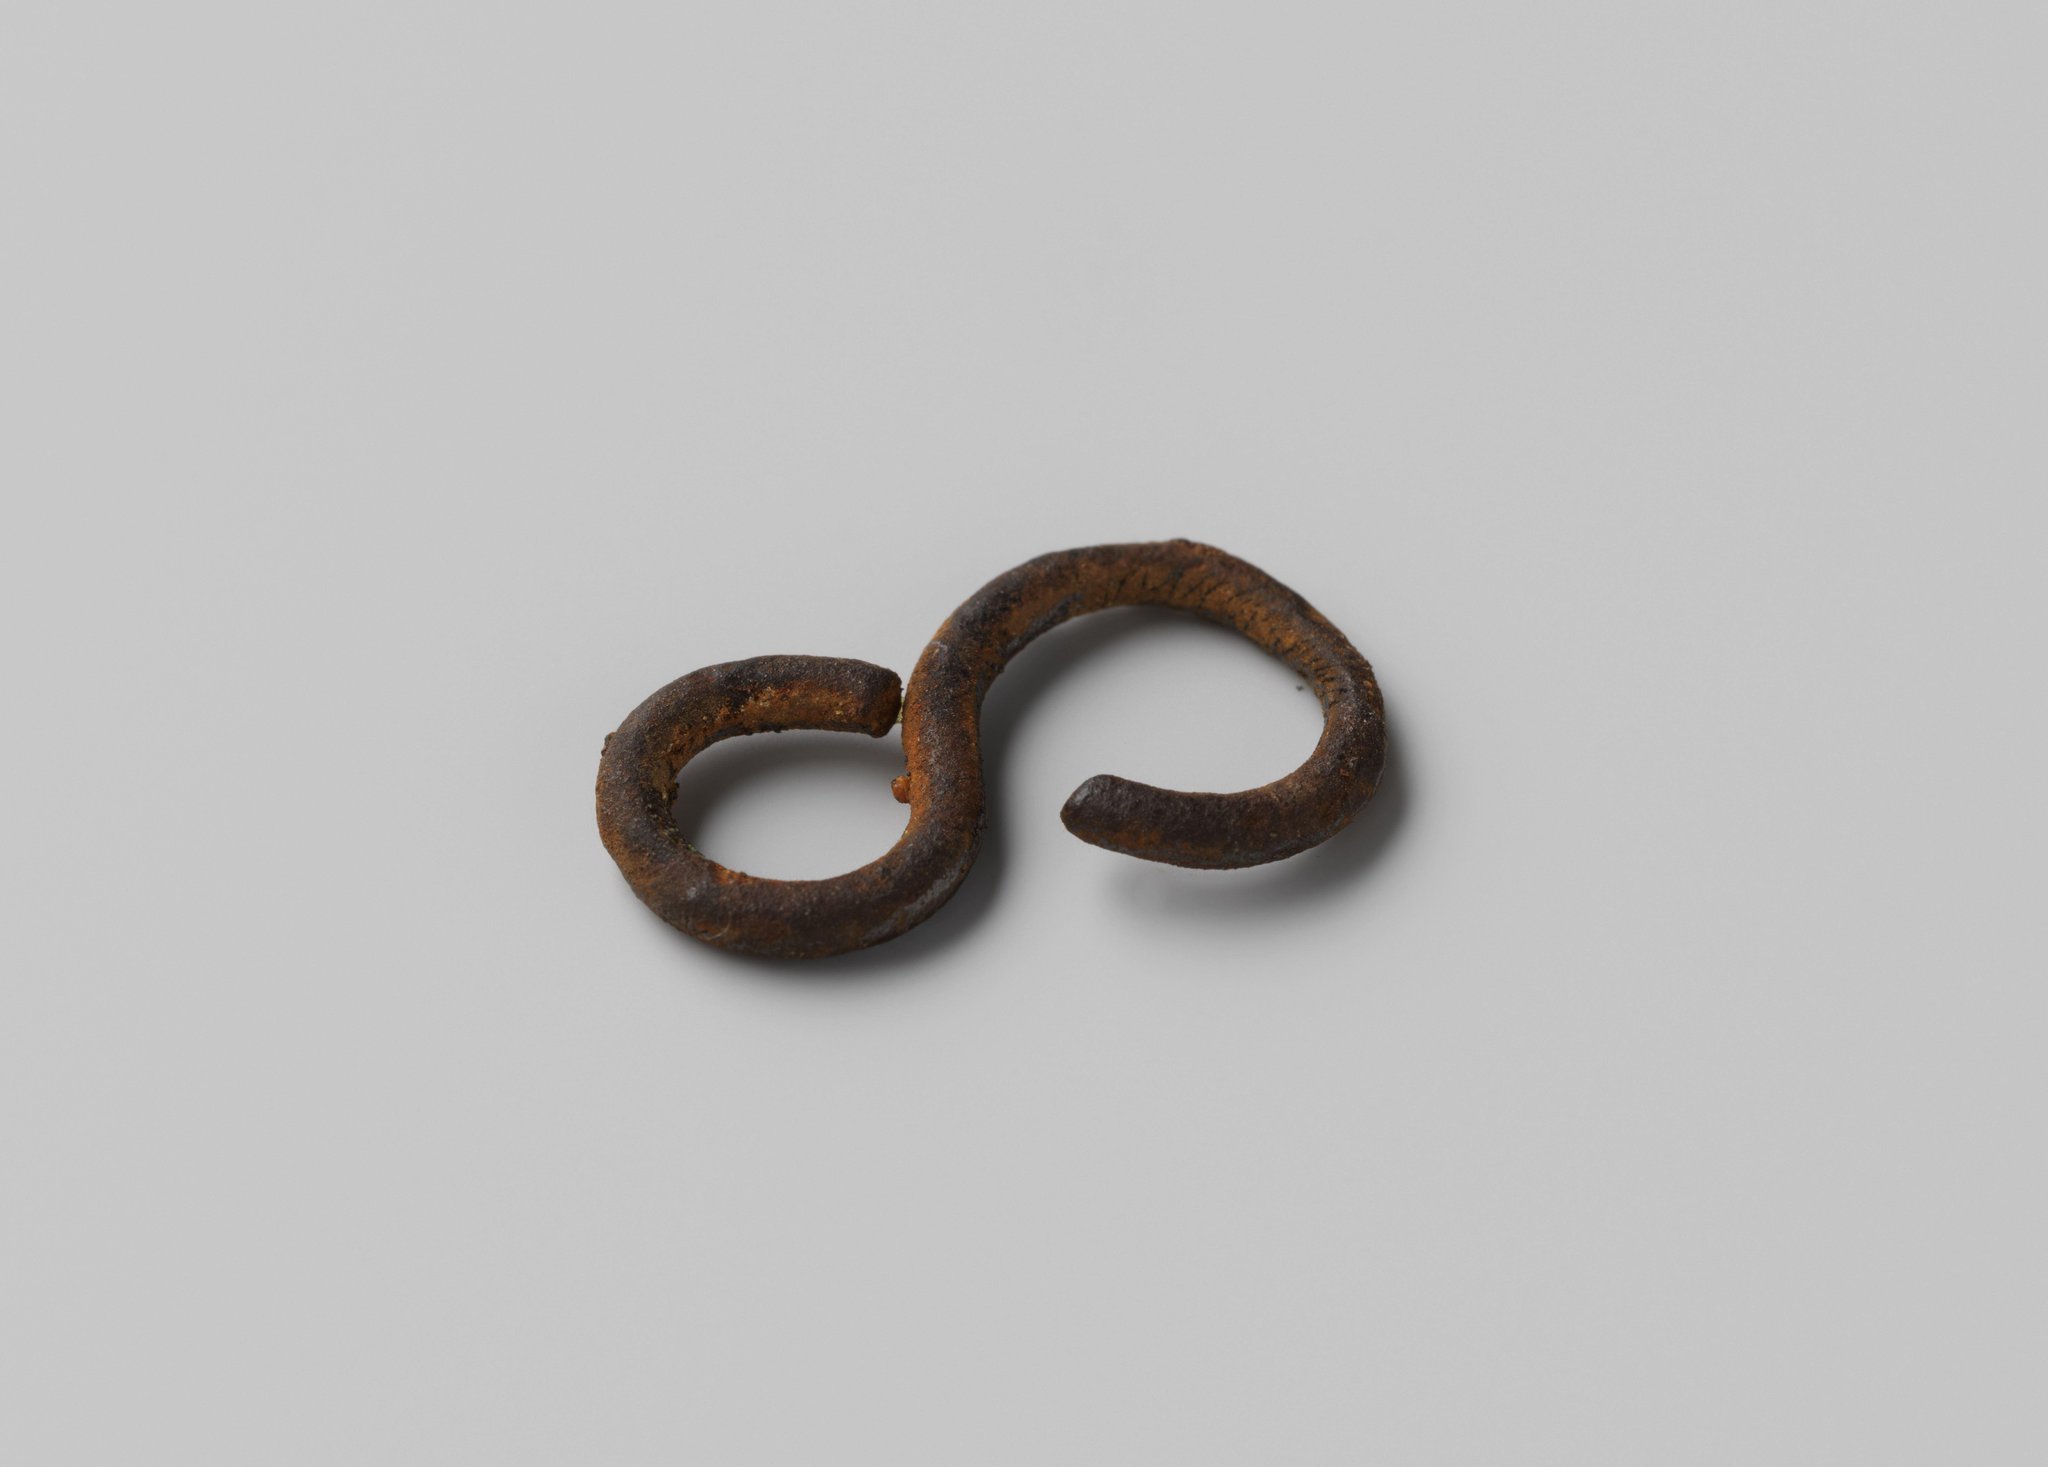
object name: chain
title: Schakel van een ketting uit het wrak van de Oost-Indiëvaarder Hollandia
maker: Anonymous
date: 1700-1743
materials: copper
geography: netherlands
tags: verenigde oostindische compagnie, hollandia (schip), annet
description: Varied parts or fragments, chains; fragm, link, of wire, figure-of-eight-shaped, flat.